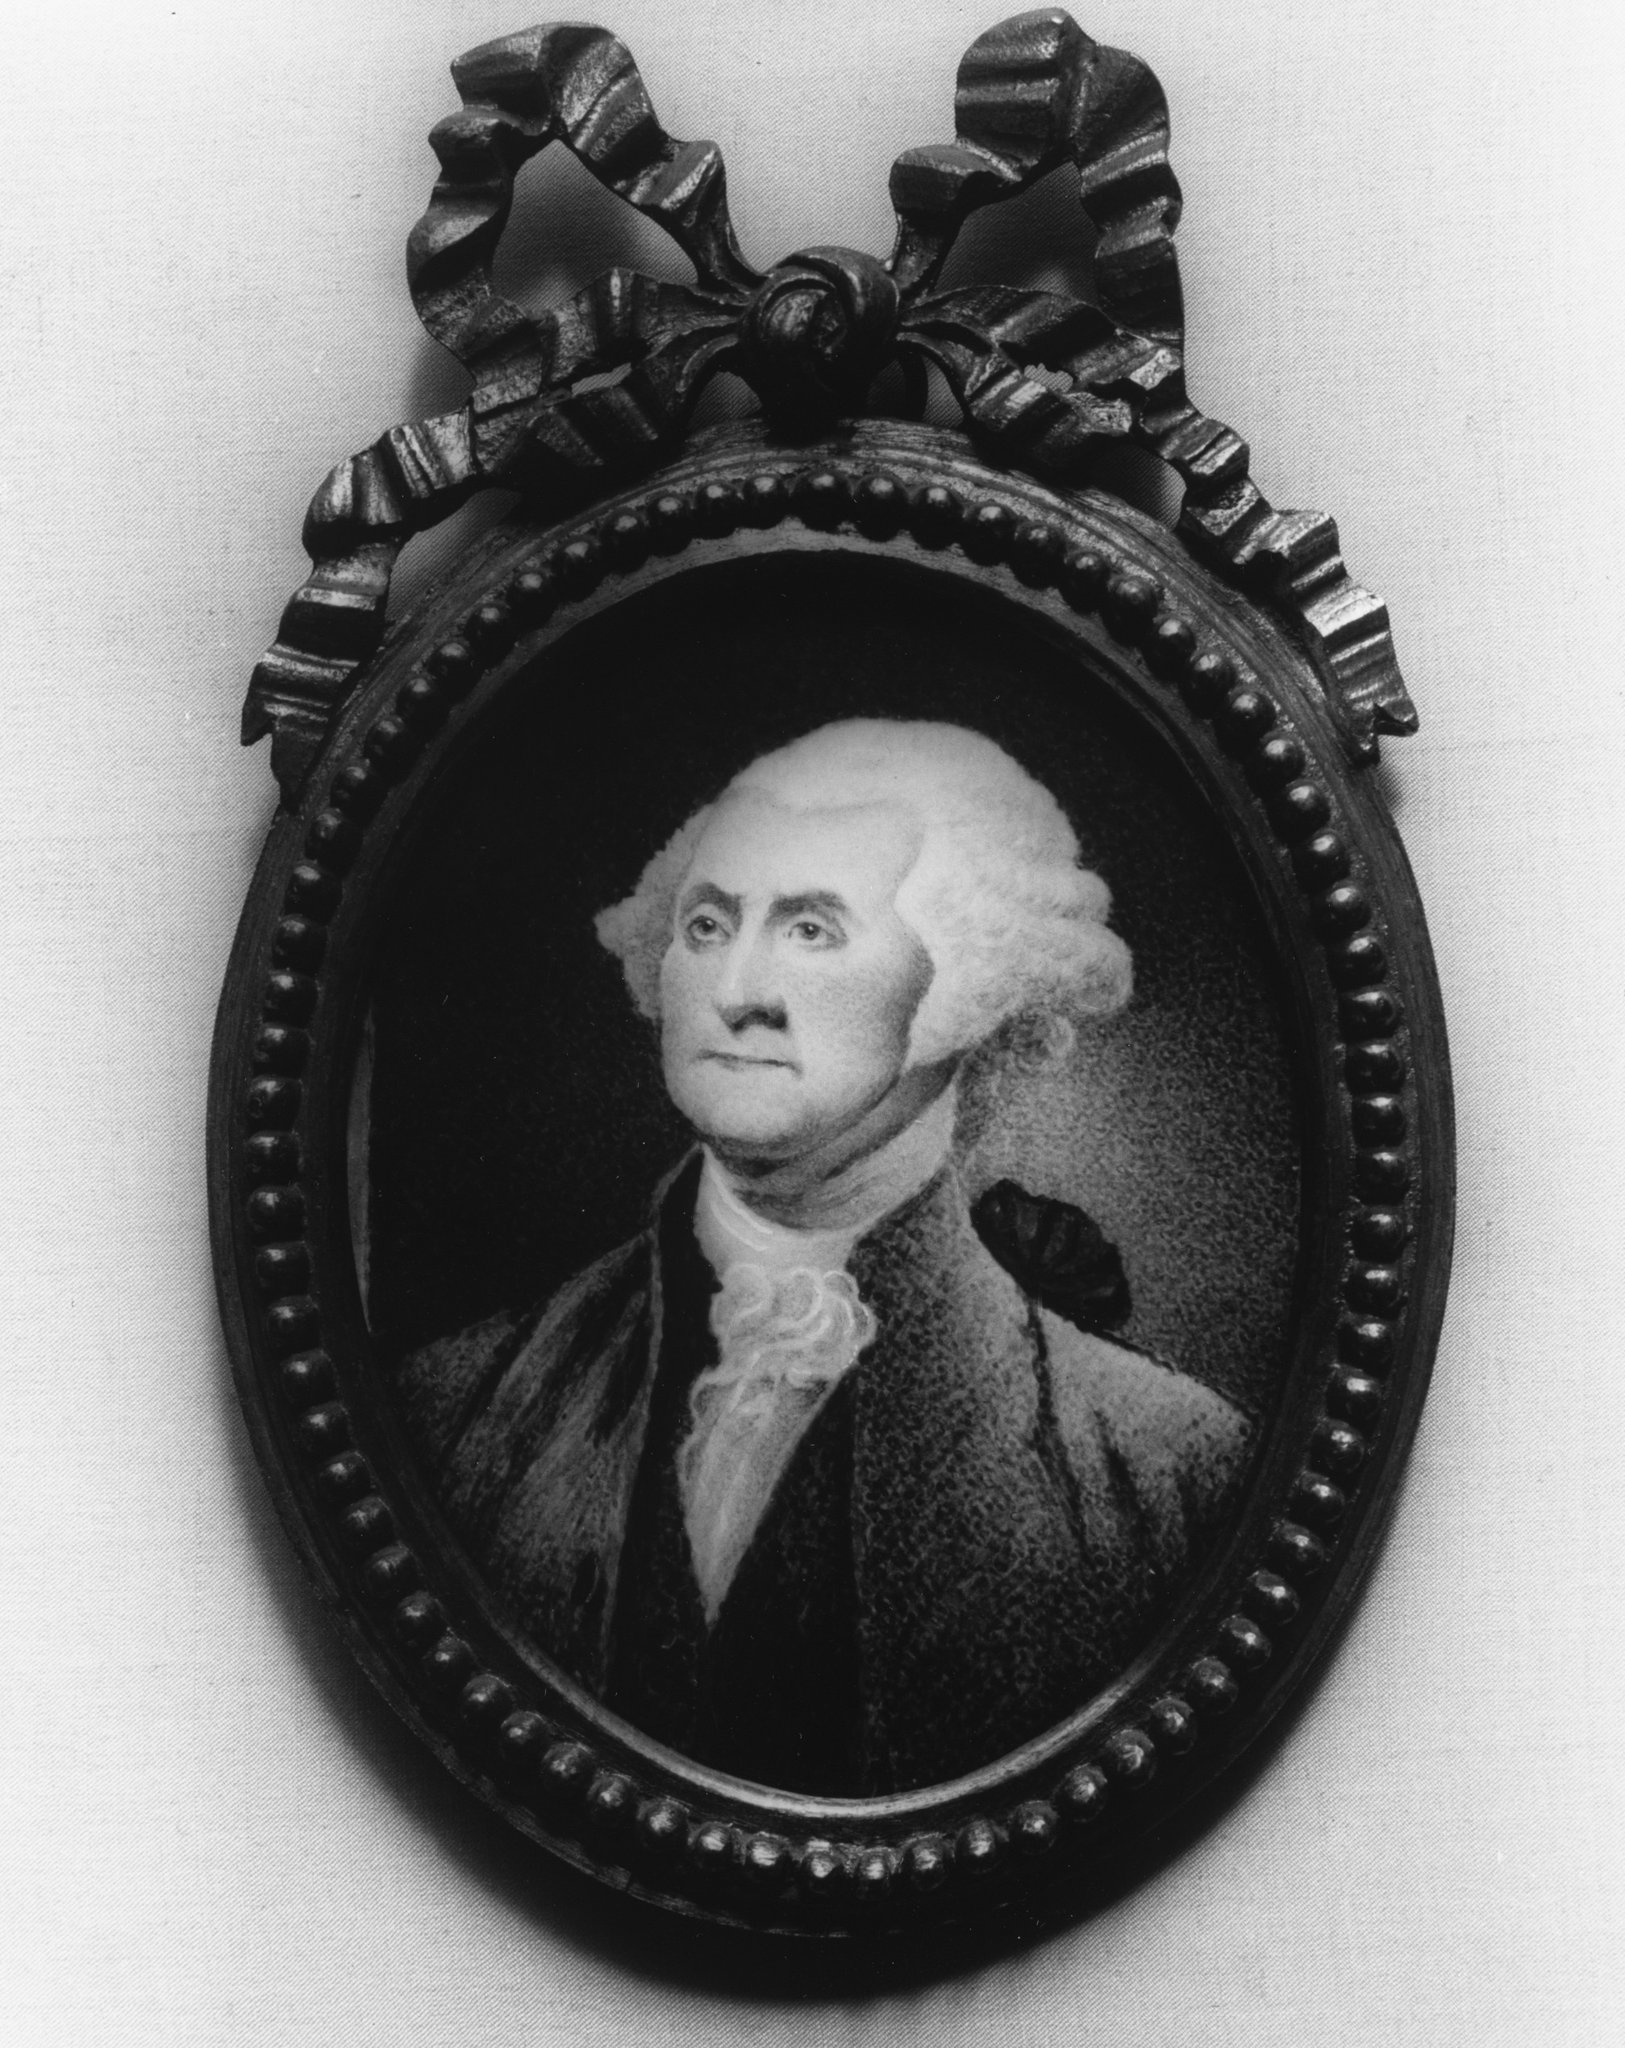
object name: plaque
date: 1800-1830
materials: ivory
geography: france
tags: men,portraits